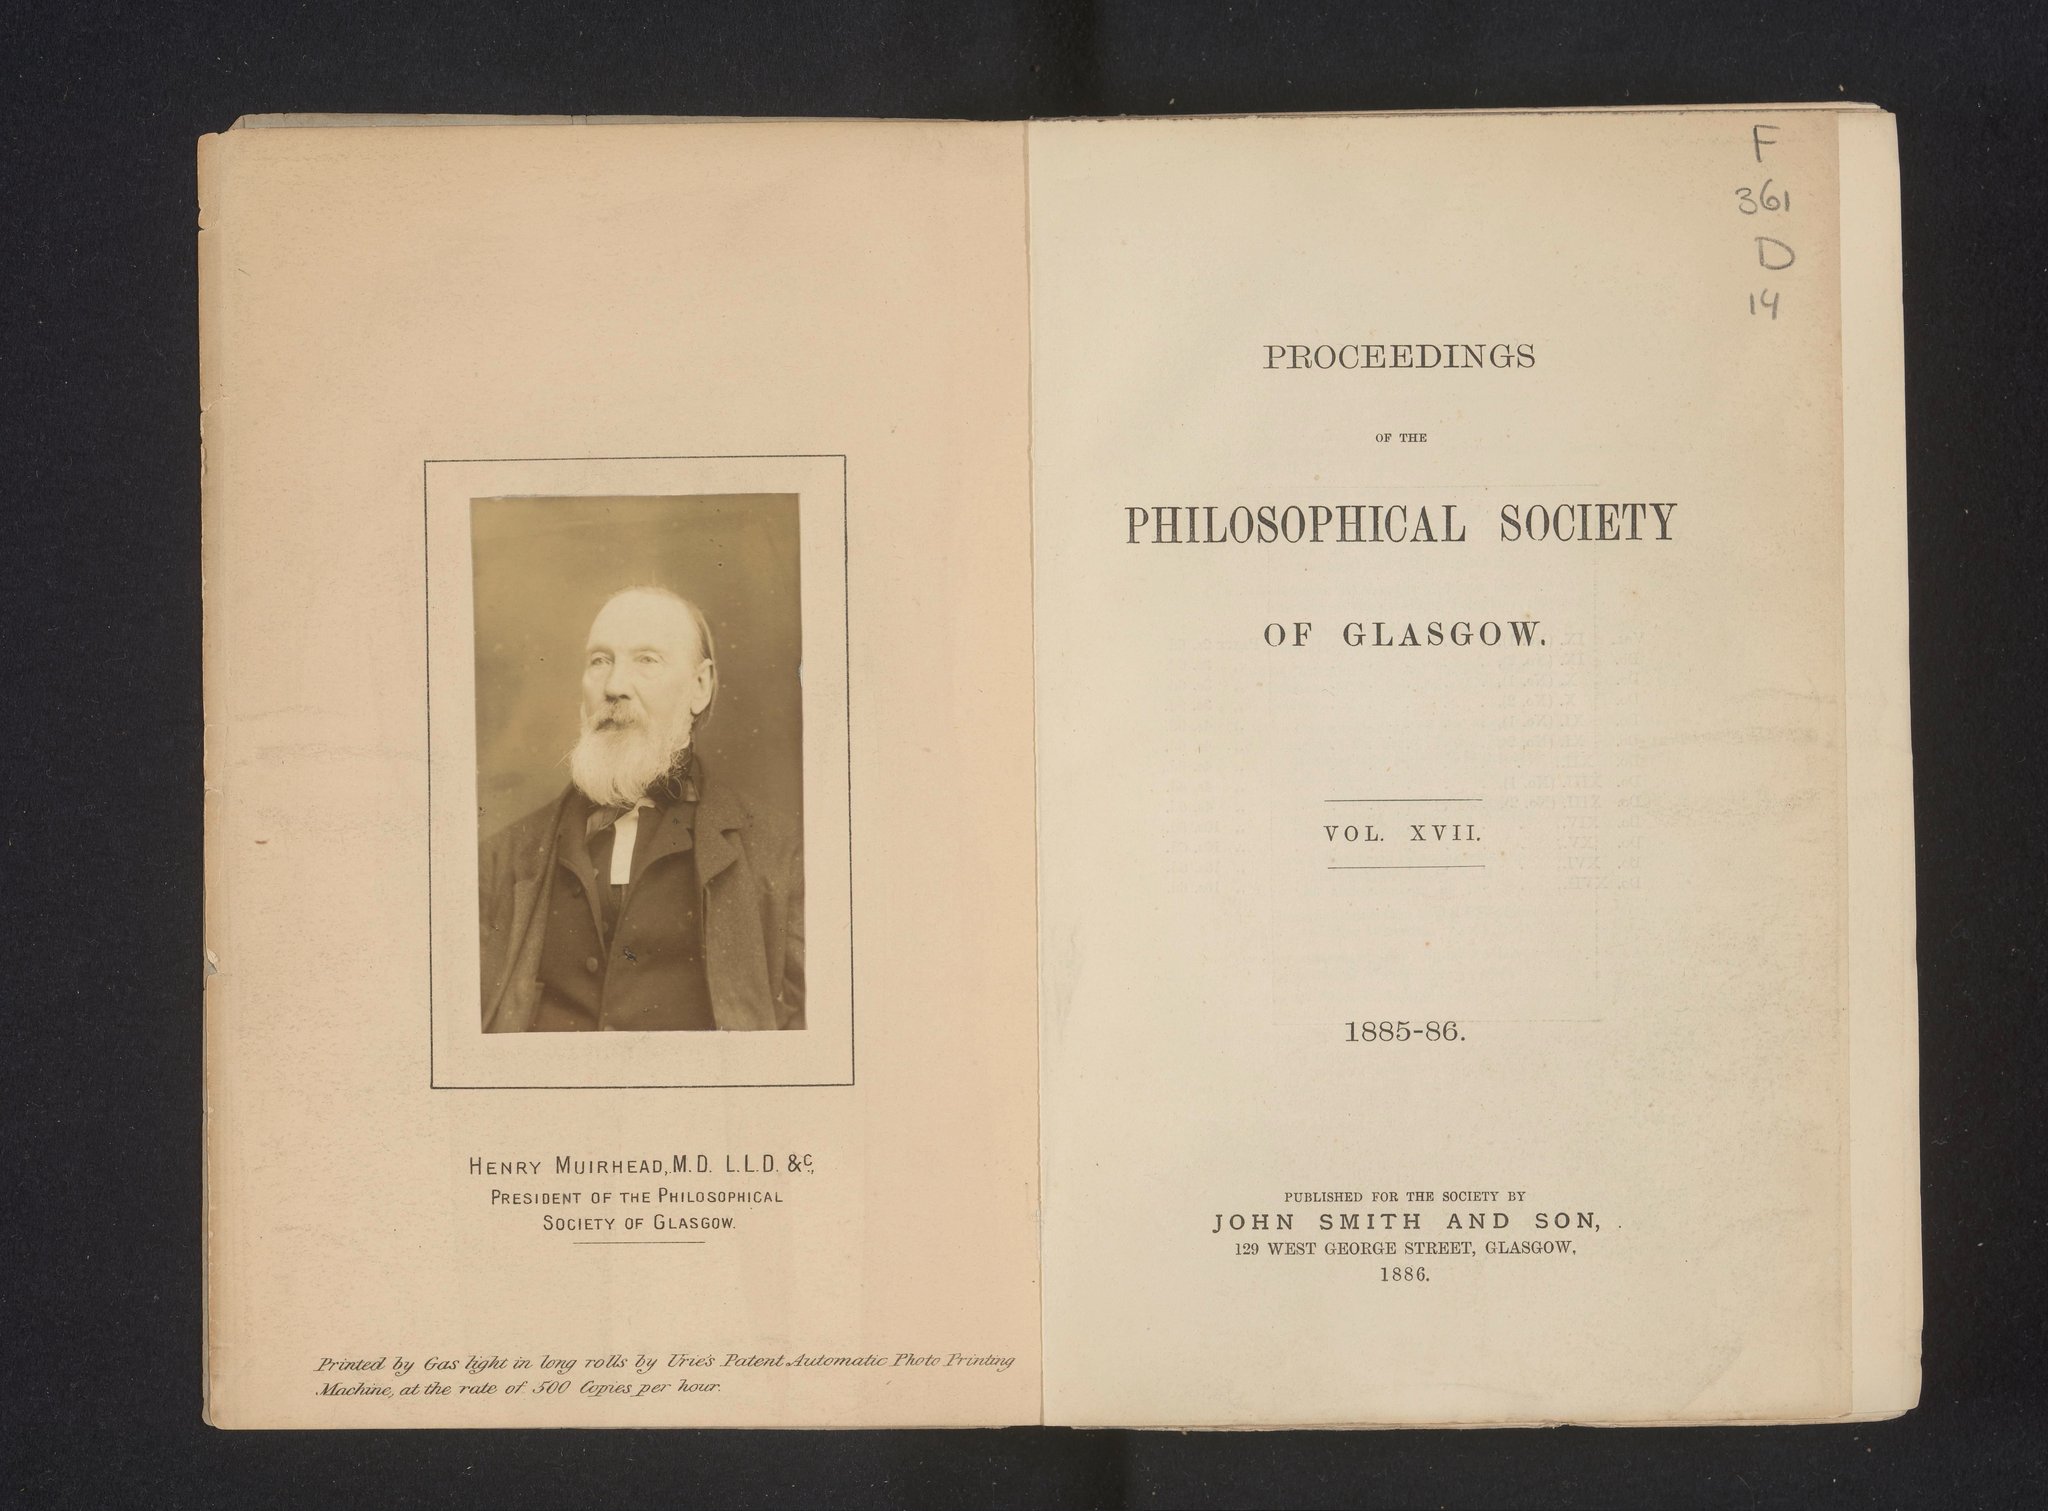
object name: book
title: Proceedings of the Philosophical Society of Glasgow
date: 1886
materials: linen, paper, photographic support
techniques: photograph, lithograph, printing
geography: glasgow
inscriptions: date: ‘FEB 1998’